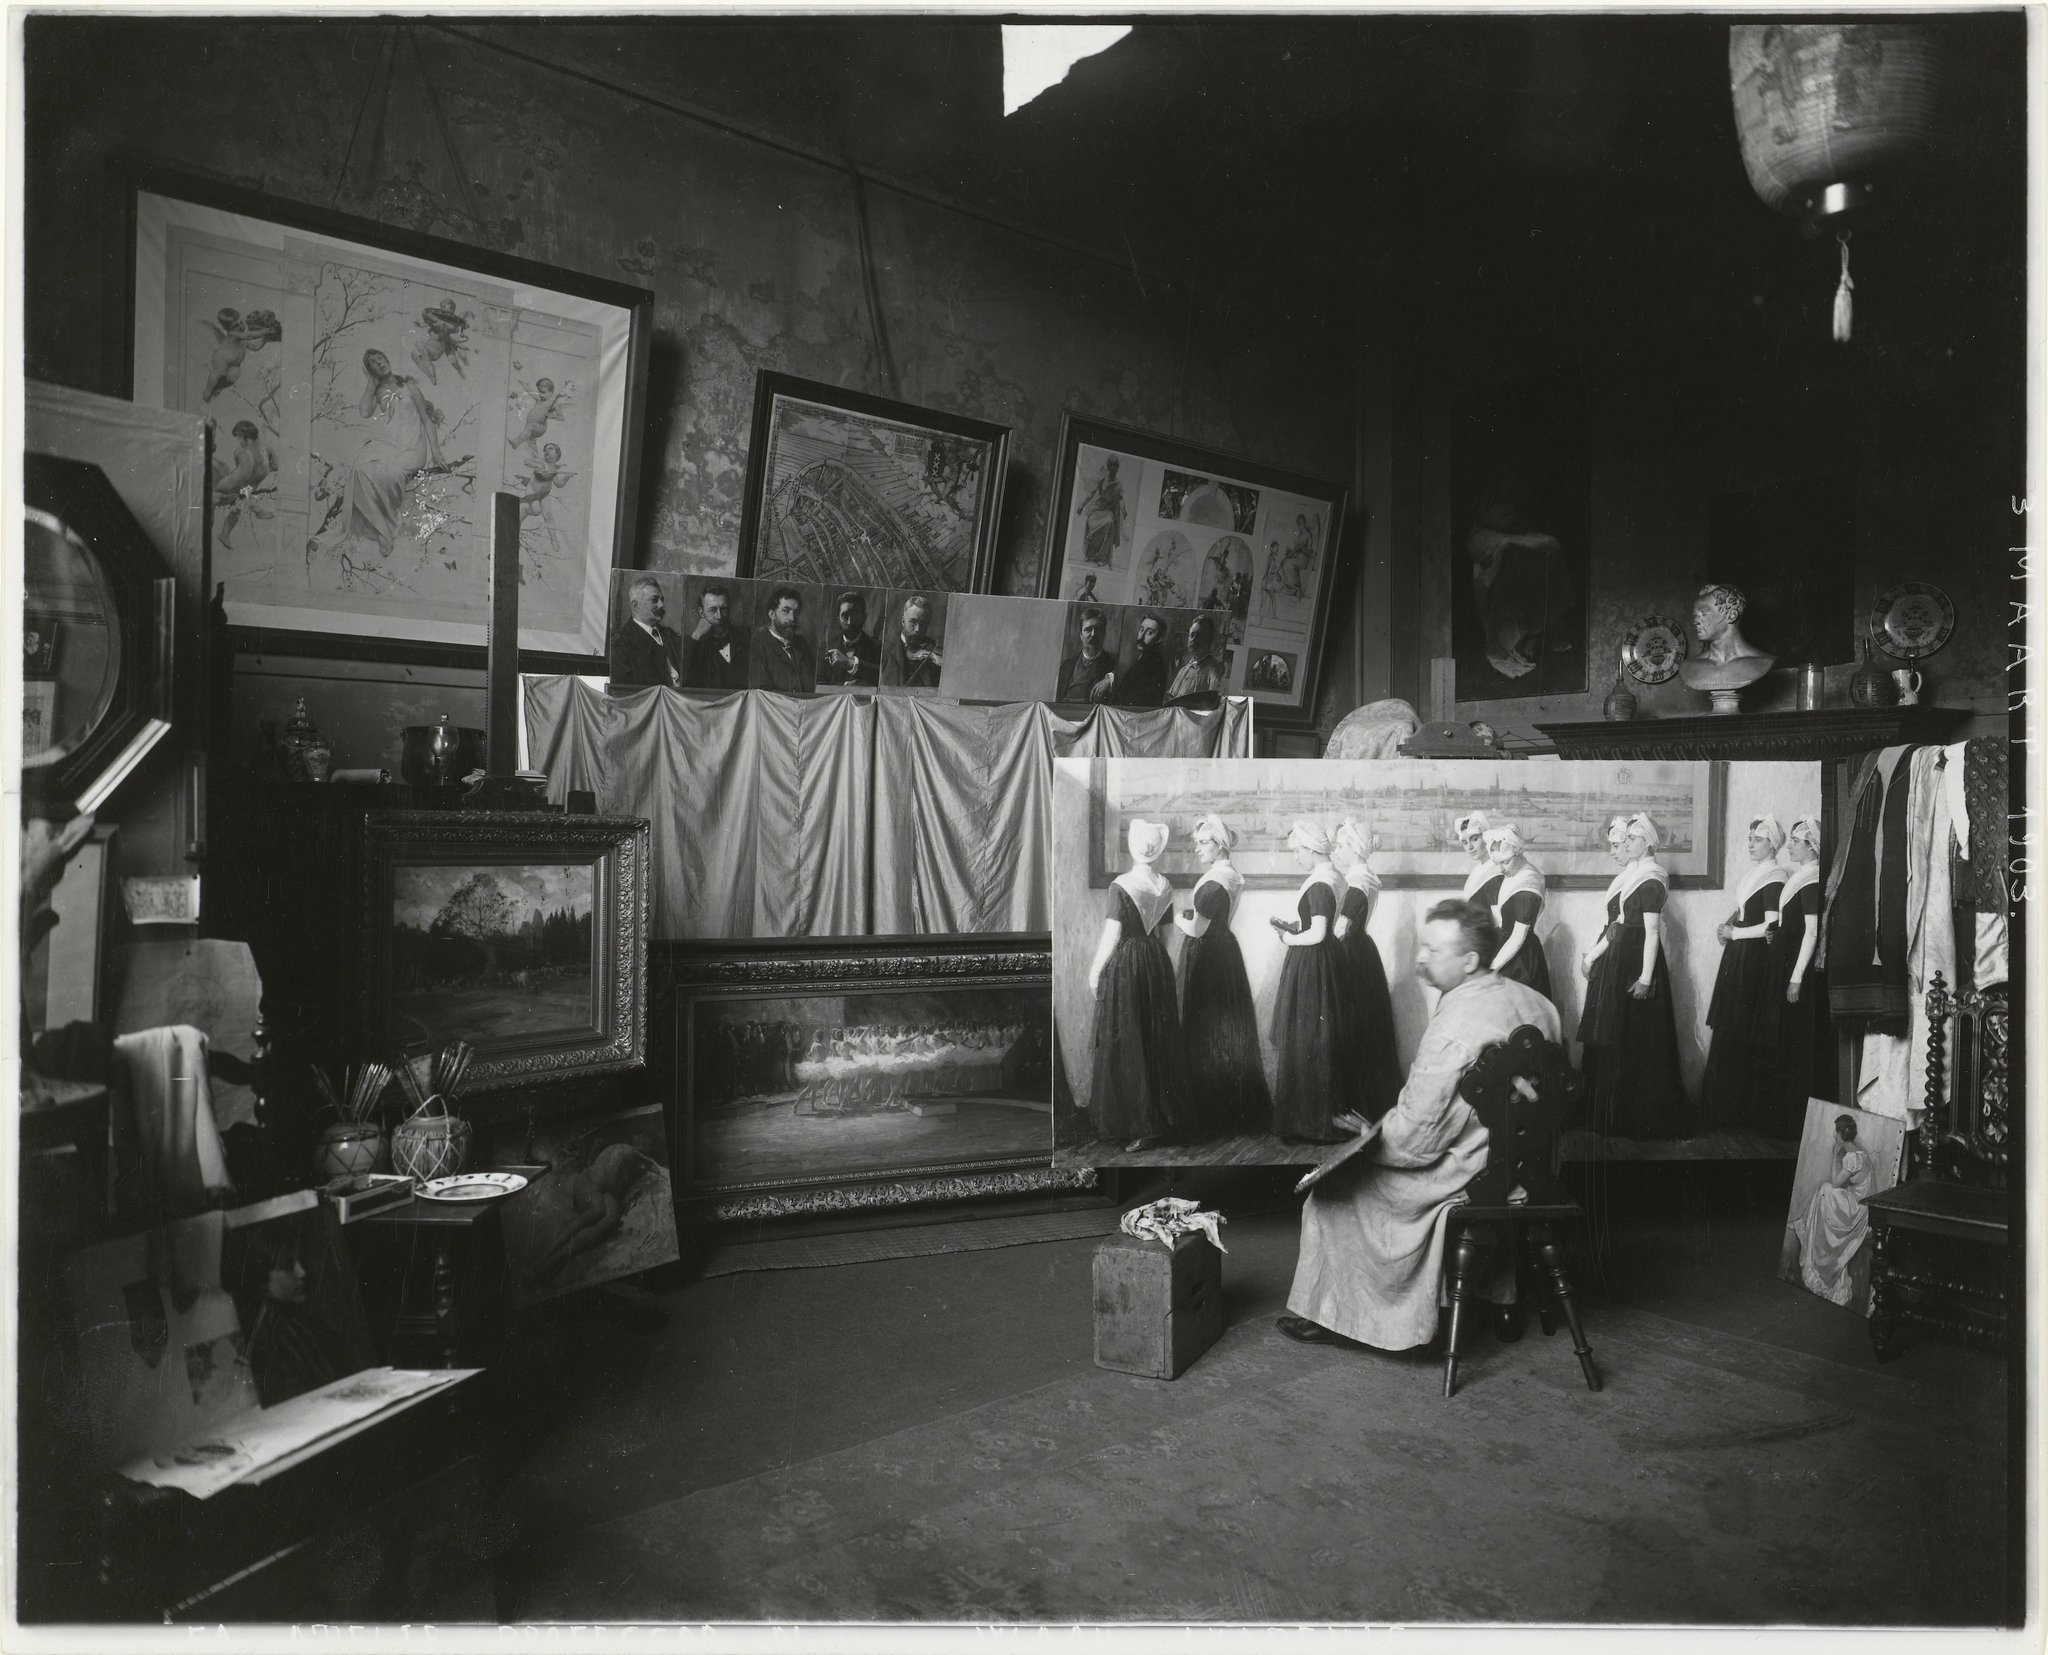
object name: photograph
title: Schilder Nicolaas van der Waay in zijn atelier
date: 1903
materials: paper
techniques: gelatin silver print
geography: amsterdam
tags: amsterdam, painter, print maker, draughtsman, nicolaas van der waay, painter at work, in his studio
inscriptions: inscription: ‘Professor N. van den Waay, academie Amsterdam’, stamp: ‘World Copyright by W.M.A. Deppe’